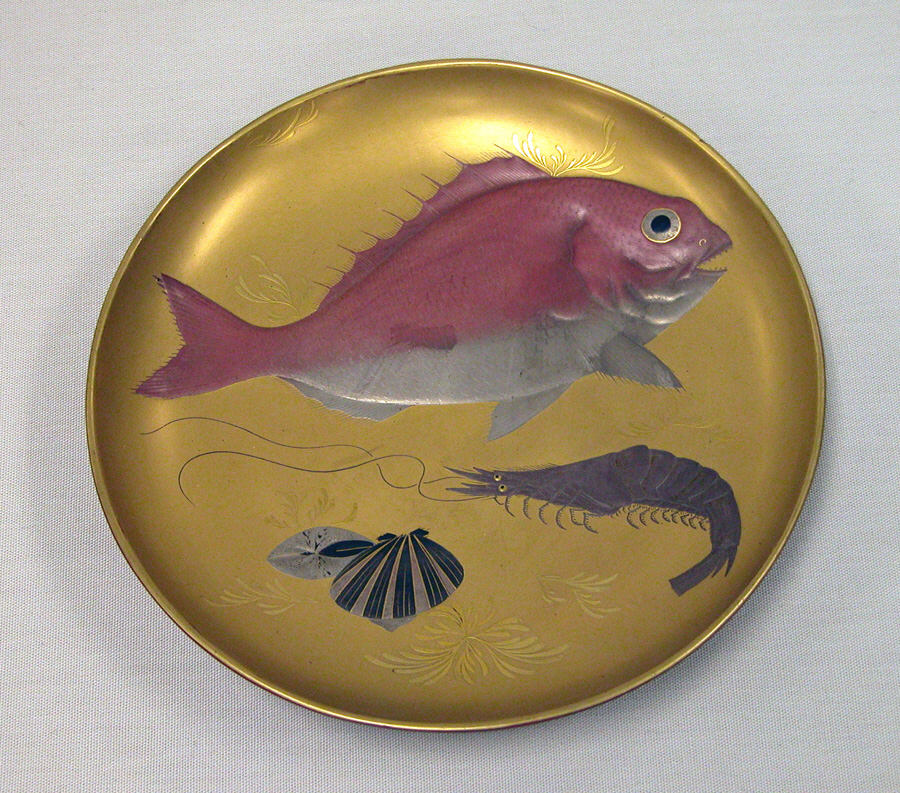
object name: wine cup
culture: japanese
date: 1801-1900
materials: gold, lacquer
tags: fish,lobsters,shells